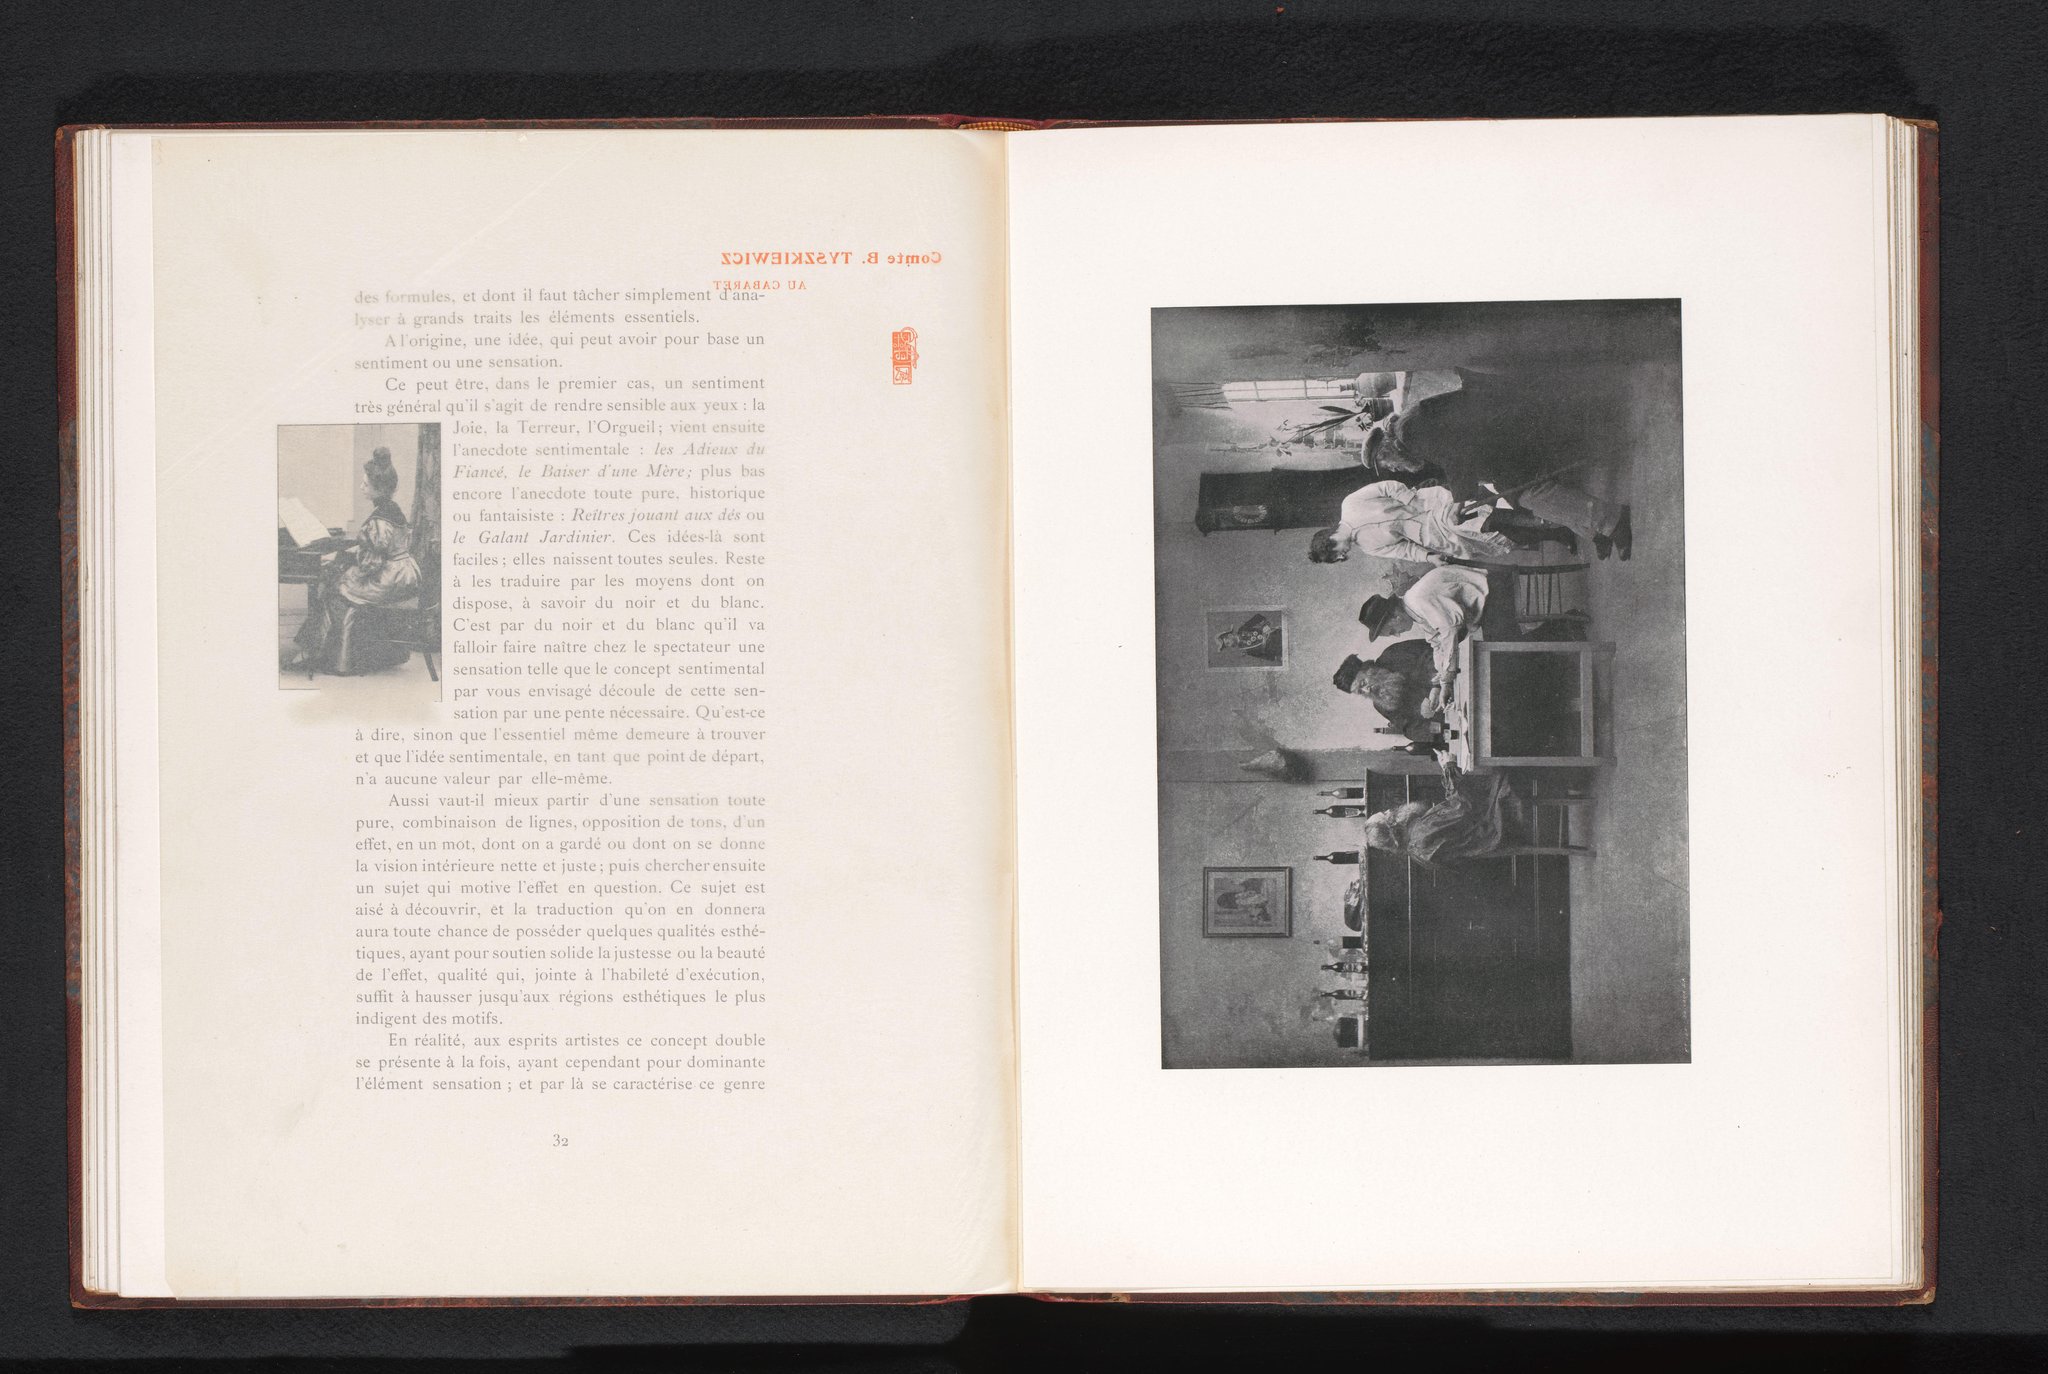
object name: page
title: Drie mannen spelen een kaartspel, twee anderen kijken toe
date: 1895-1900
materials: paper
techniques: autotype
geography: brussels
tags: card games (+ sportsman, player, etc.)